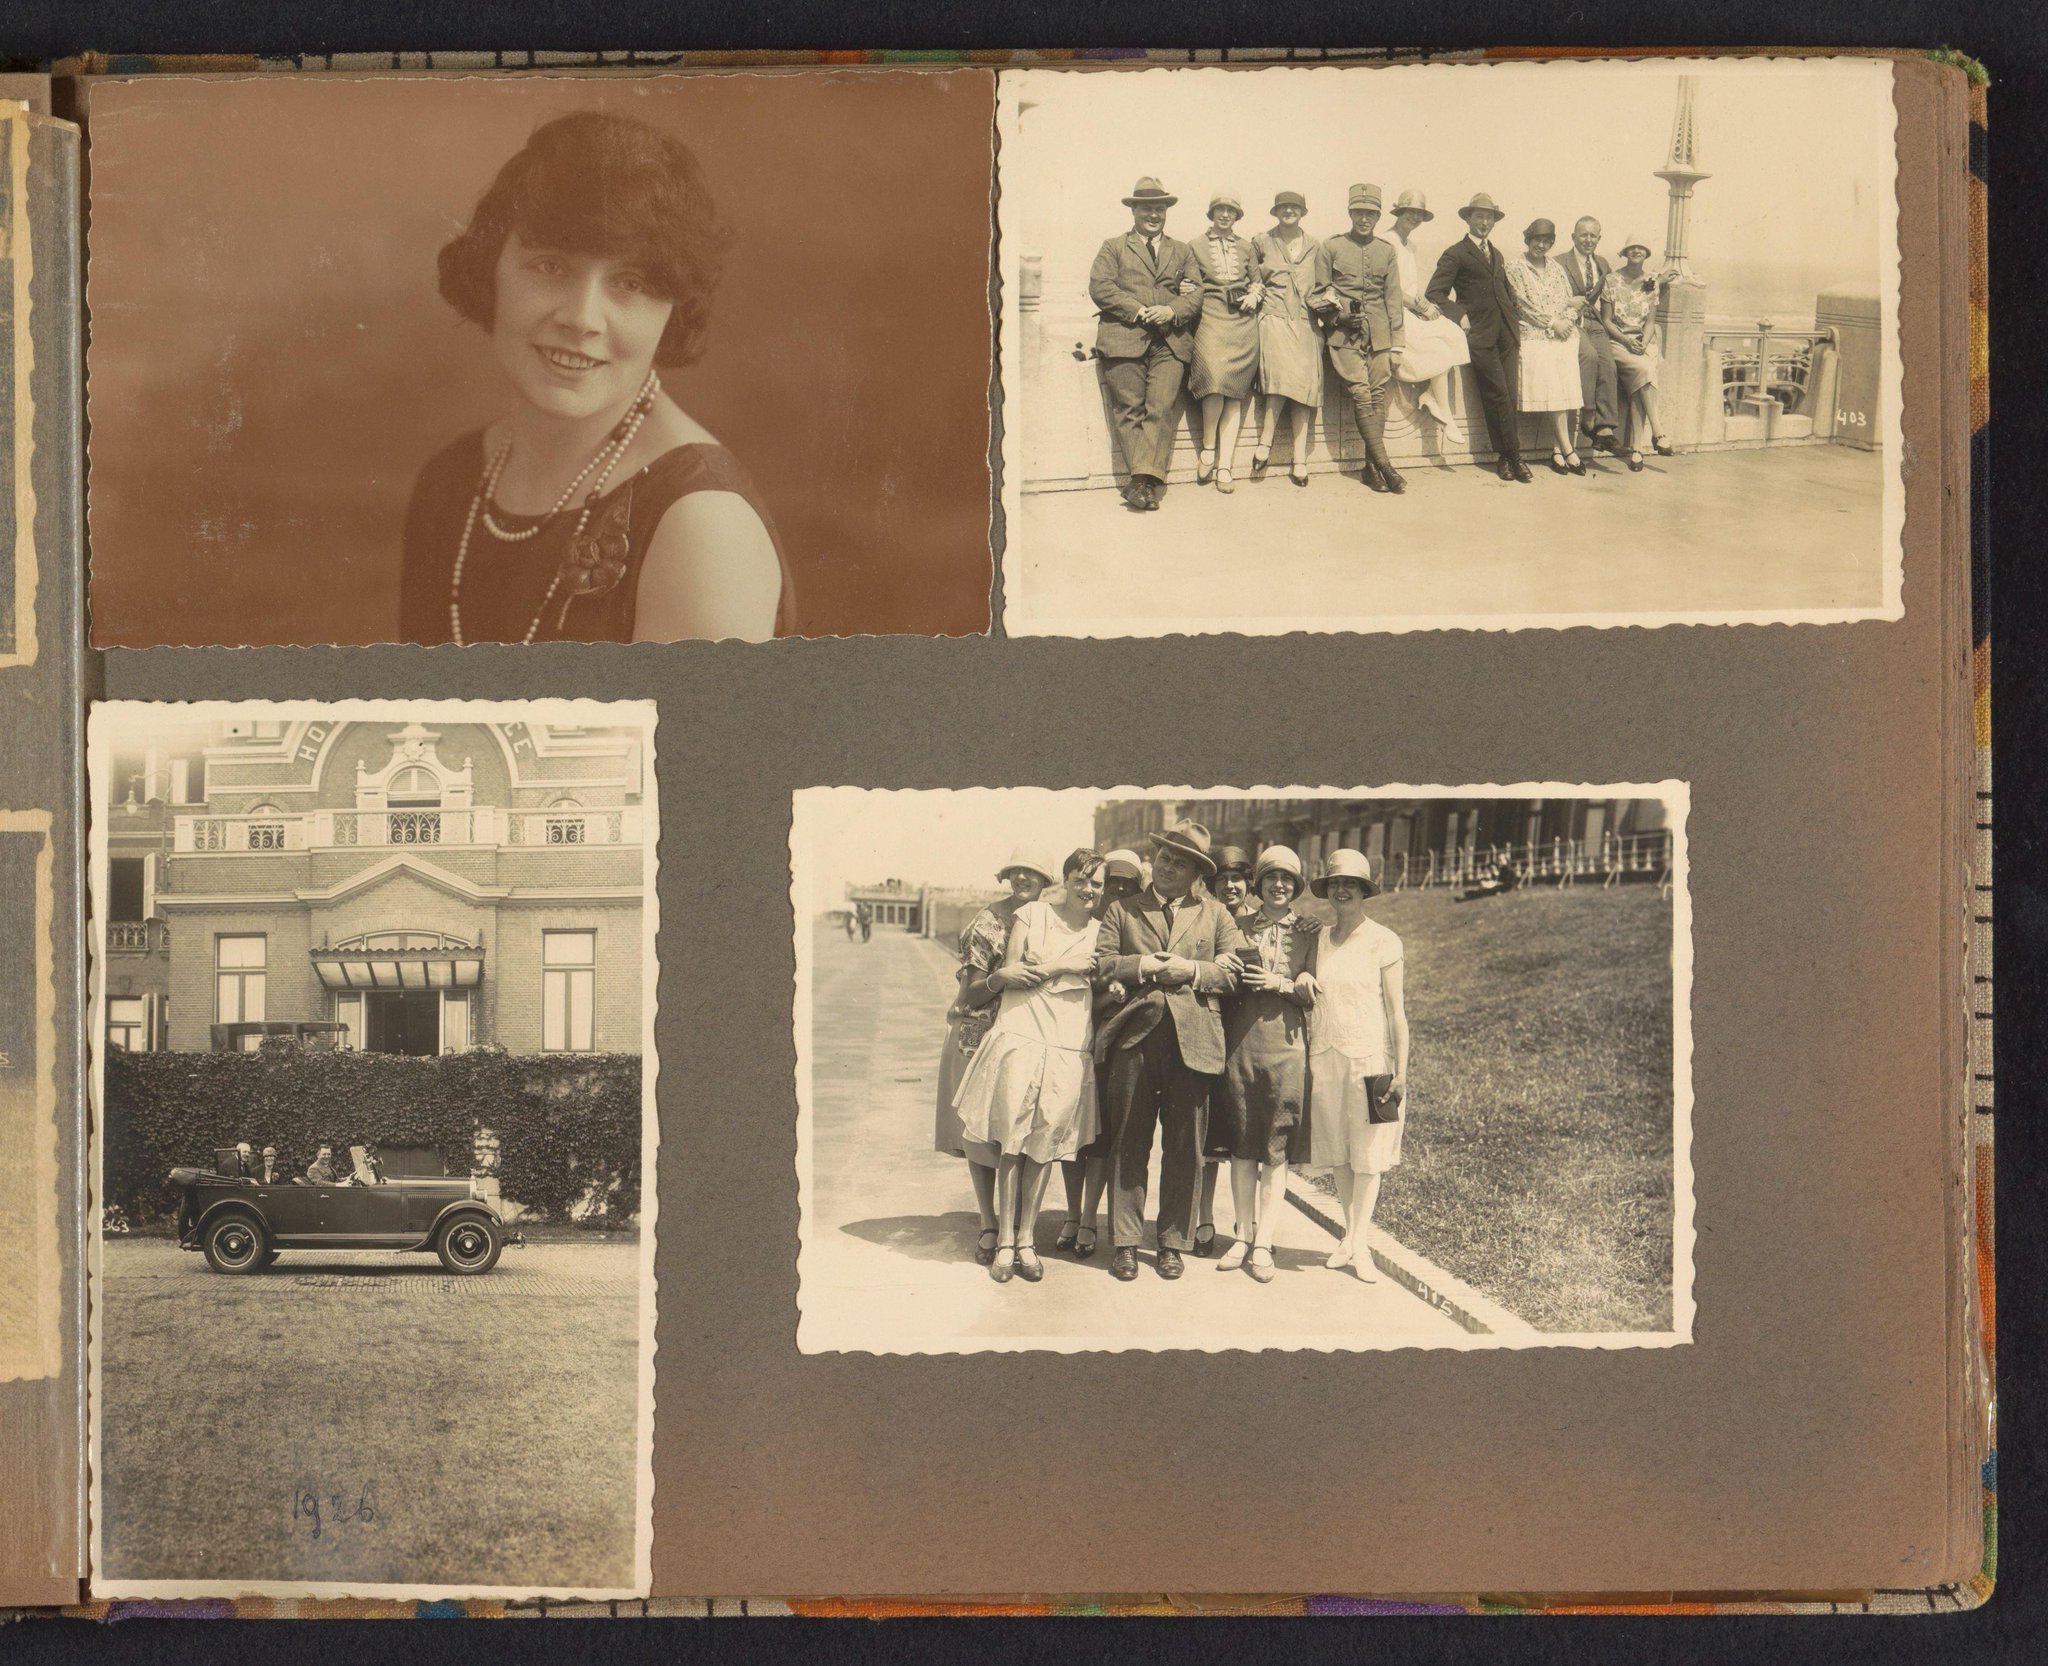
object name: photograph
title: Gezelschappen en portret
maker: Anonymous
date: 1900-1926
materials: cardboard, photographic support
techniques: gelatin silver print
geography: scheveningen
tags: adult woman, adult man, automobile, hotel, hostelry, inn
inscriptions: number: ‘403’, number: ‘415’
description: Albumblad met foto's van een gezelschap, vermoedelijk op de boulevard van Scheveningen. Ook een portret van een jonge vrouw en van een gezelschap in een auto voor Hotel d'Orange aan de Gevers Deynootweg in Scheveningen. Onderdeel van Fotoalbum van een onbekende Nederlandse familie met connecties in Suriname en Nederlands-Indië (2).